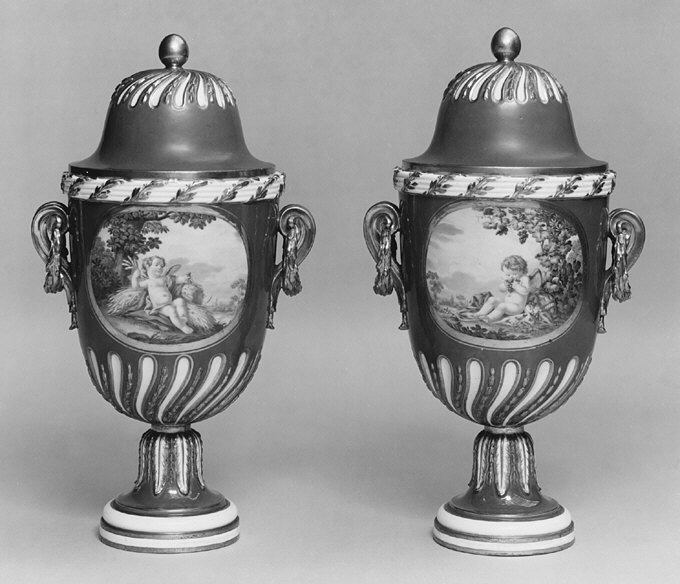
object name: vase with cover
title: Vase with cover (vase feuille de laurier) (one of a pair)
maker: sèvres manufactory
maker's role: manufactory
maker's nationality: french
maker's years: 1740-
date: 1770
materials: soft paste porcelain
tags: putti